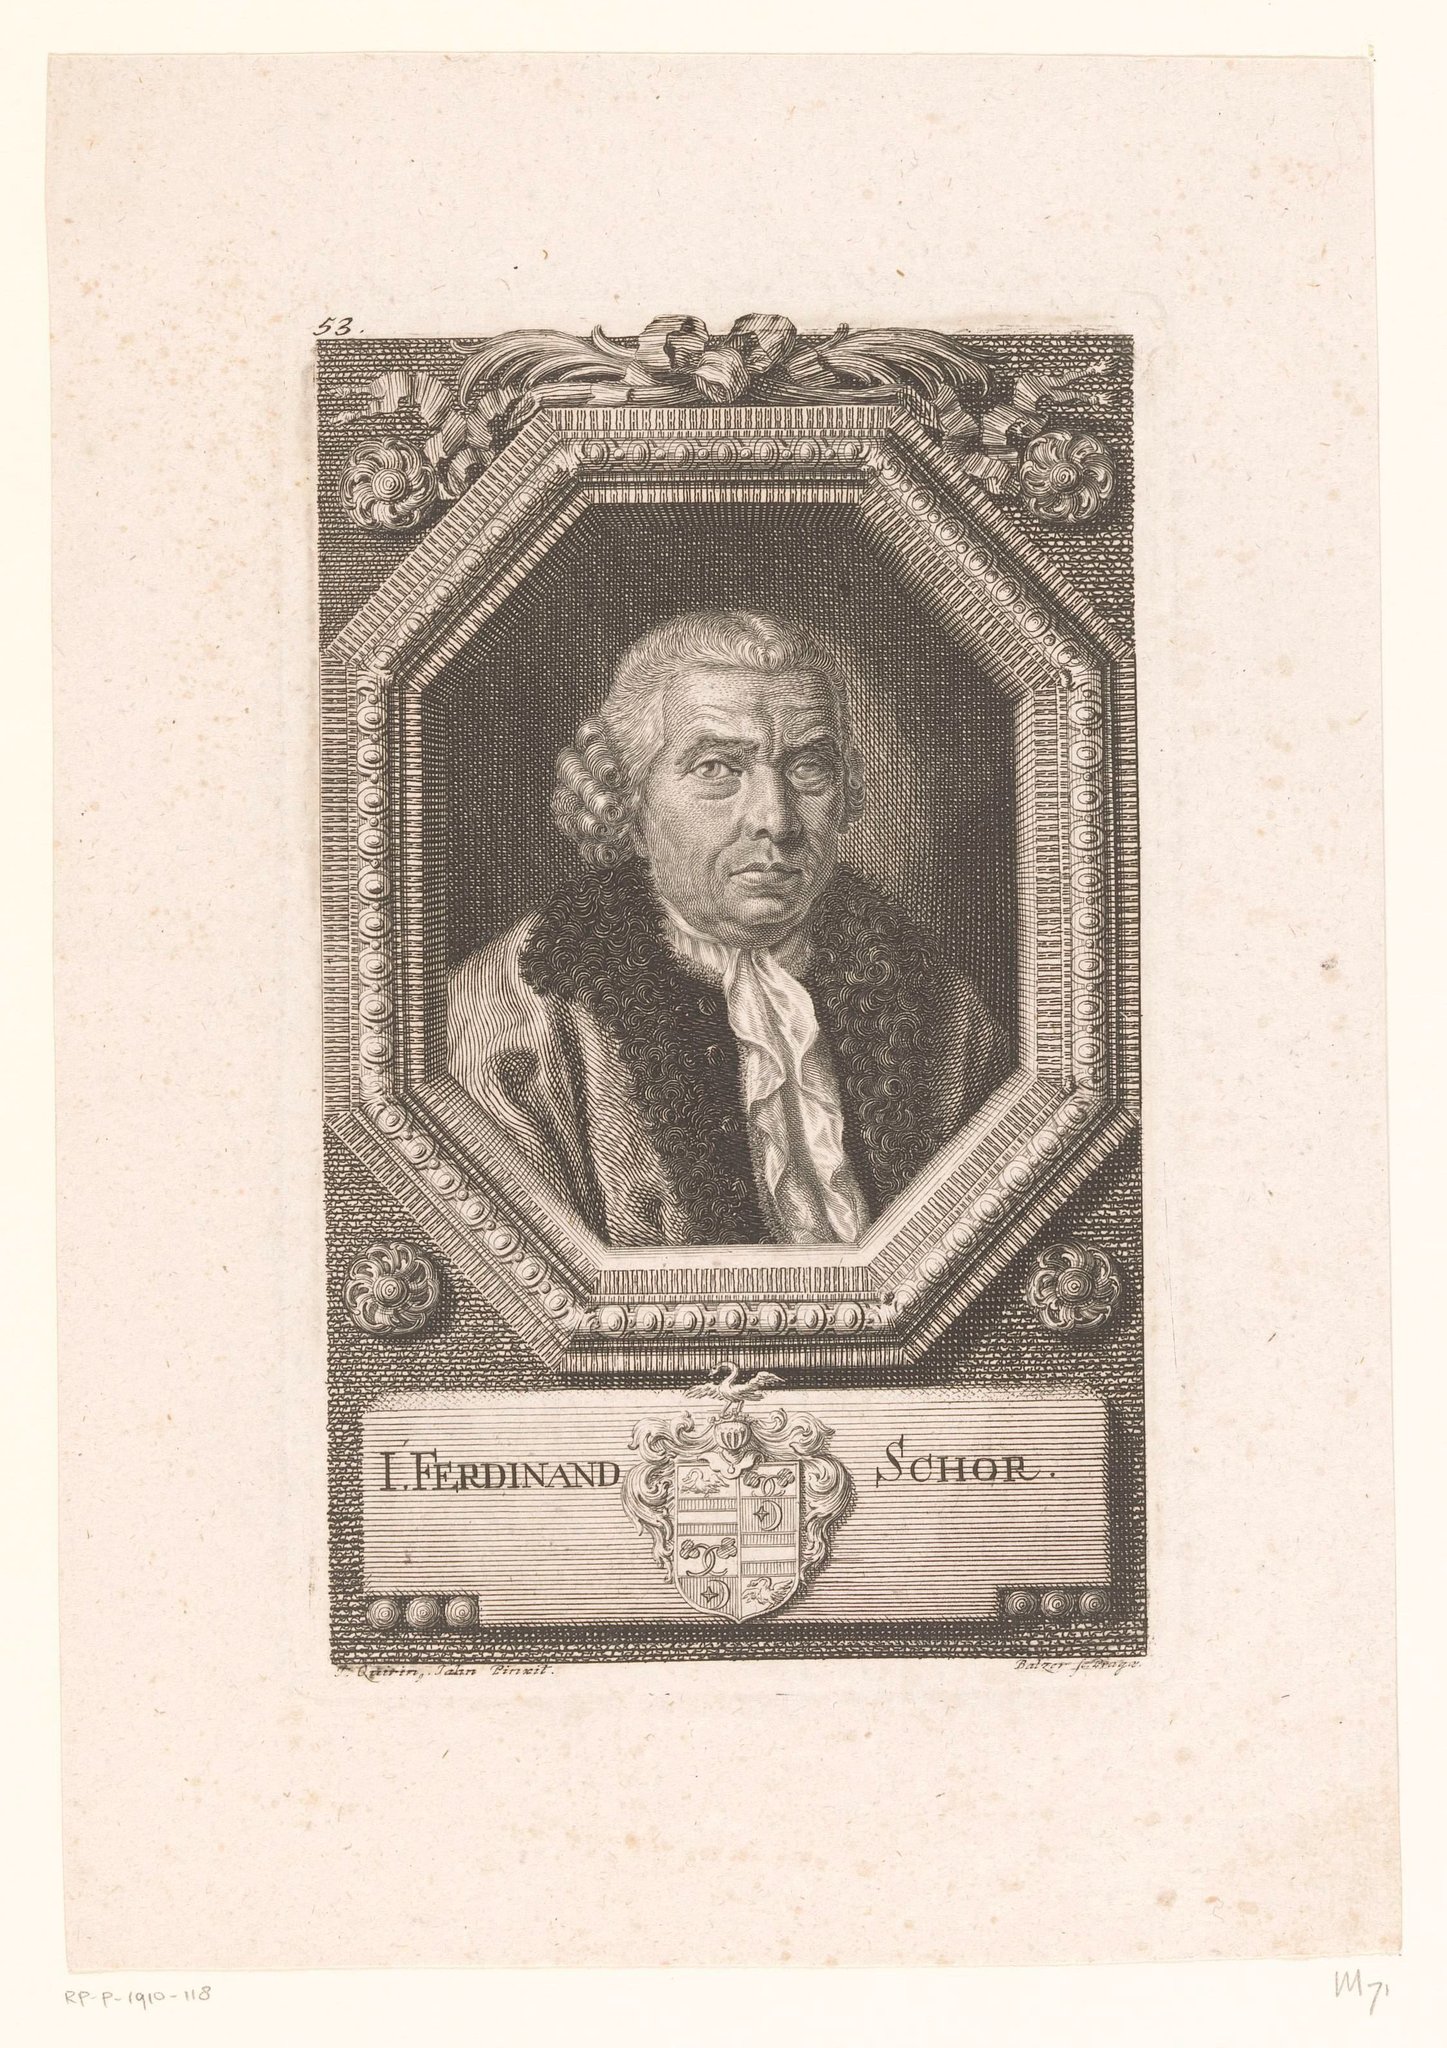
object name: print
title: I. Ferdinand Schor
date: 1749-1799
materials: paper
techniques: engraving, etching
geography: prague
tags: prague, painter, historical persons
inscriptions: collector's mark: Lugt 2228